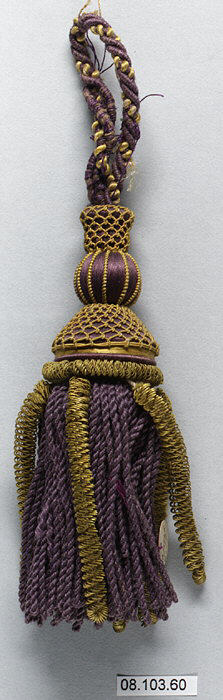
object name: tassel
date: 1801-1900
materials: silk